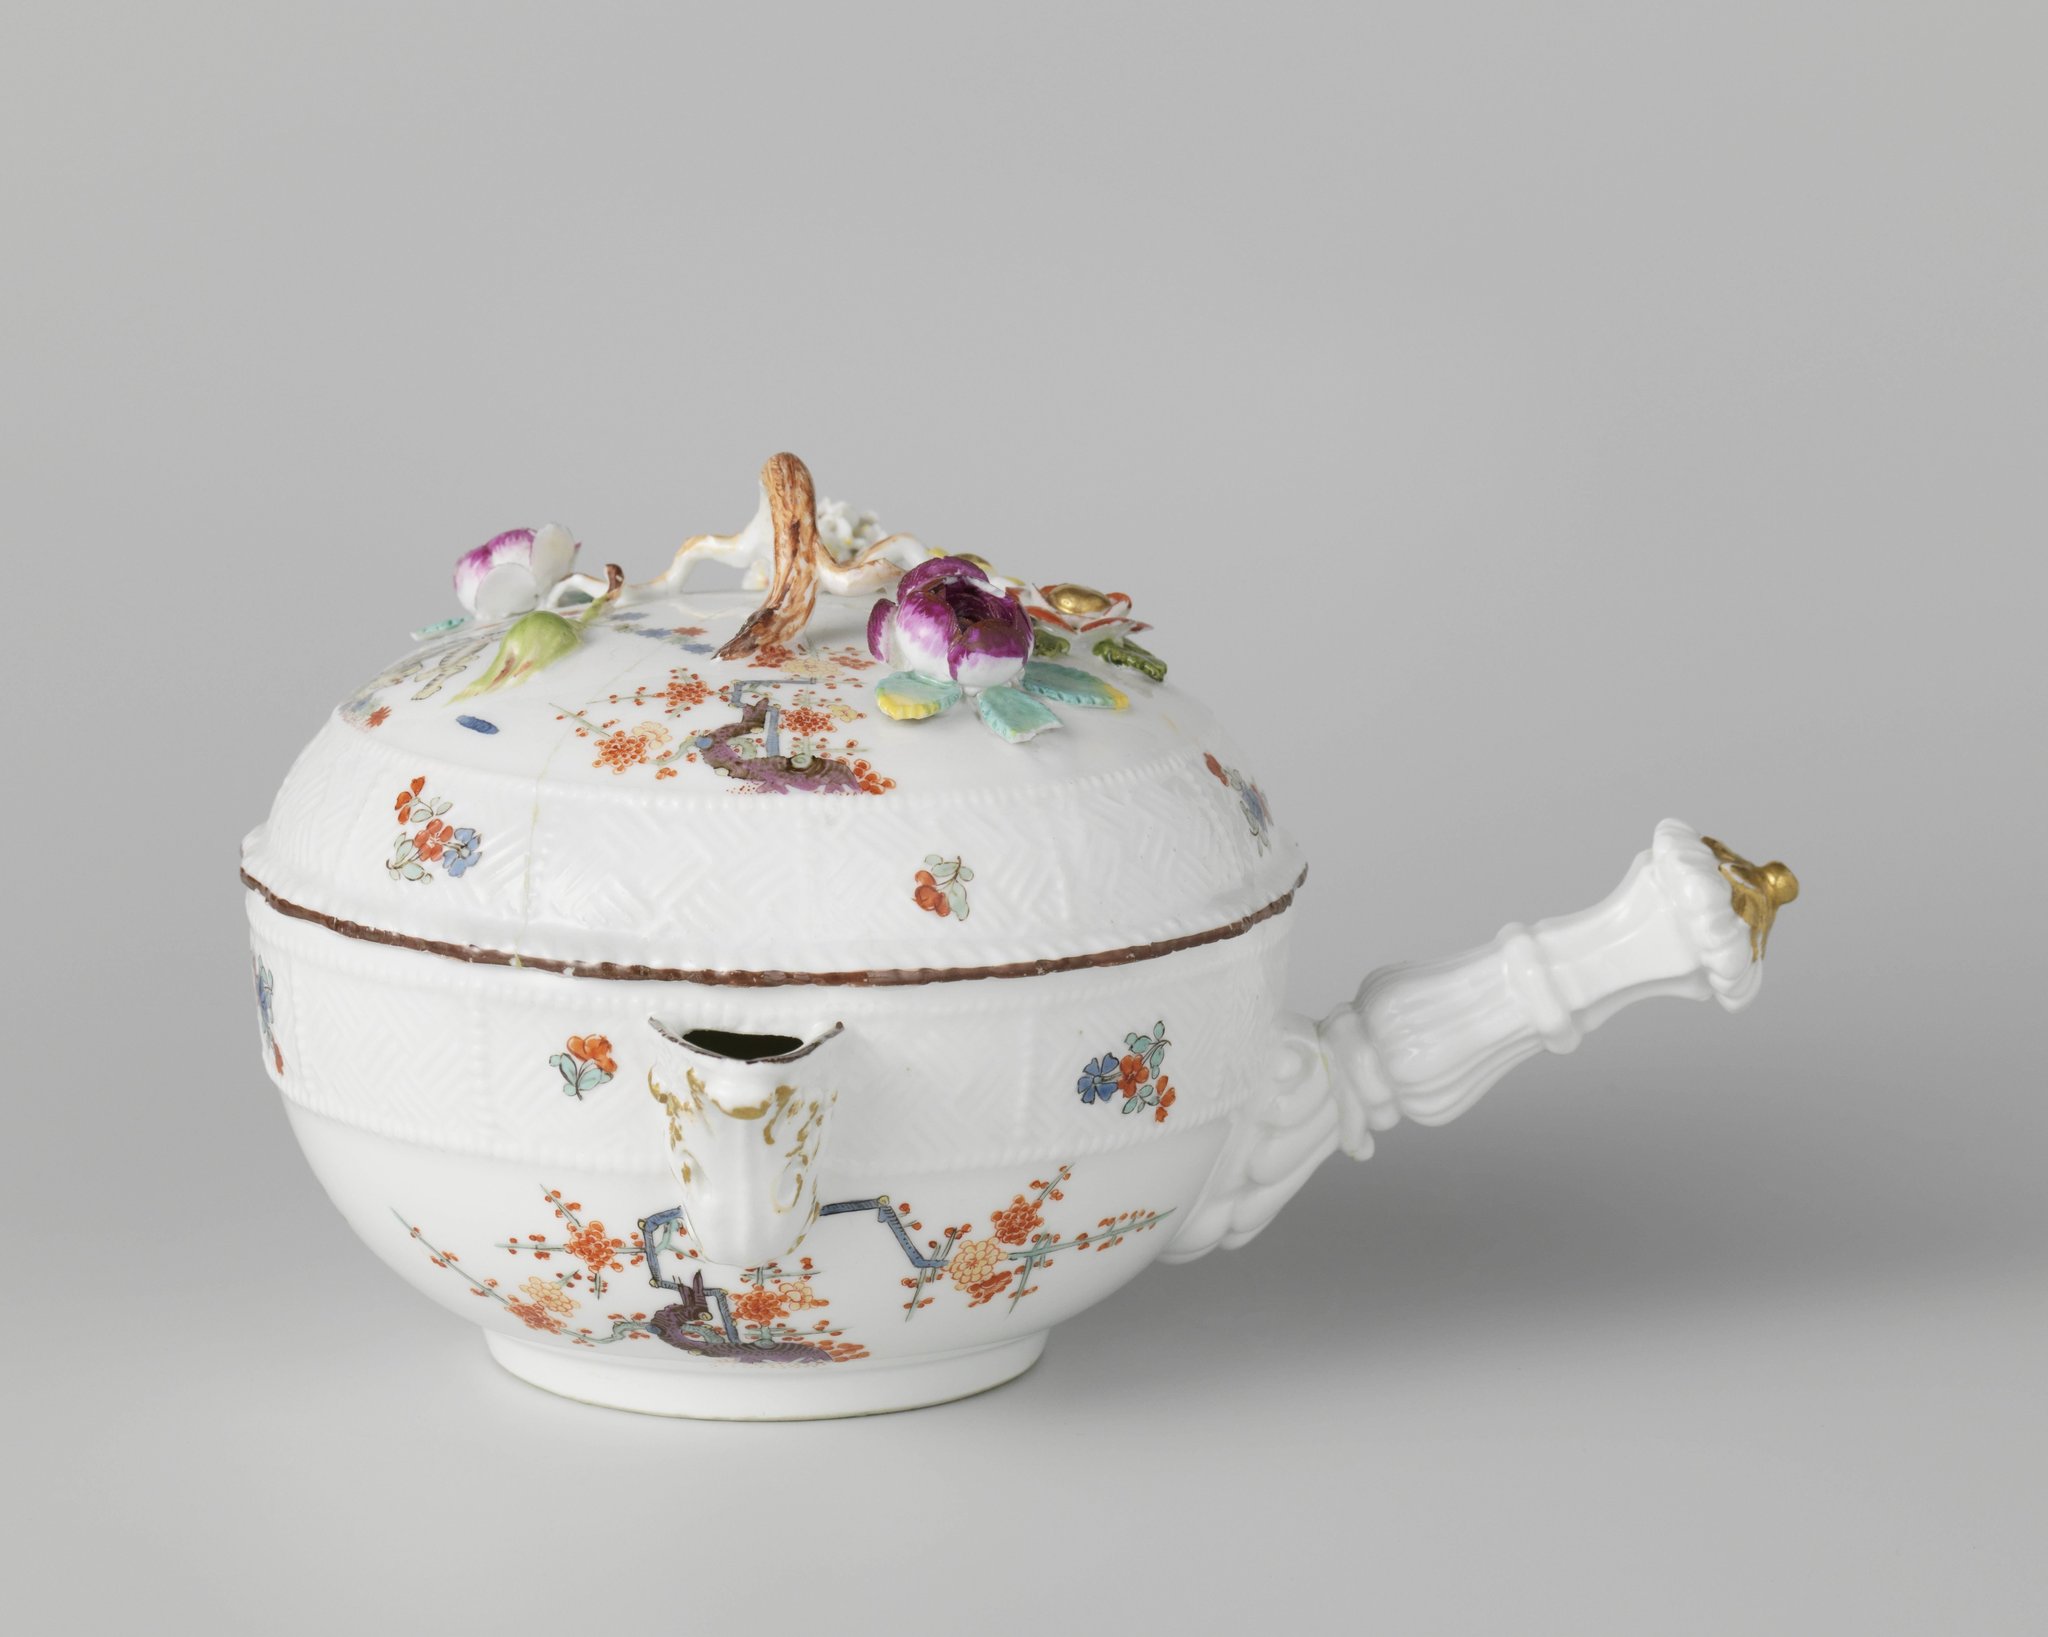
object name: eating drinking utensil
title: Terrine met deksel en handvat, veelkleurig beschilderd met een Kakiemon-decor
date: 1740-1745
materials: porcelain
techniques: painted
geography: meissen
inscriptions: factory mark, mold mark: ‘20’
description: Tureen Meissen, c. 1745 - 1750